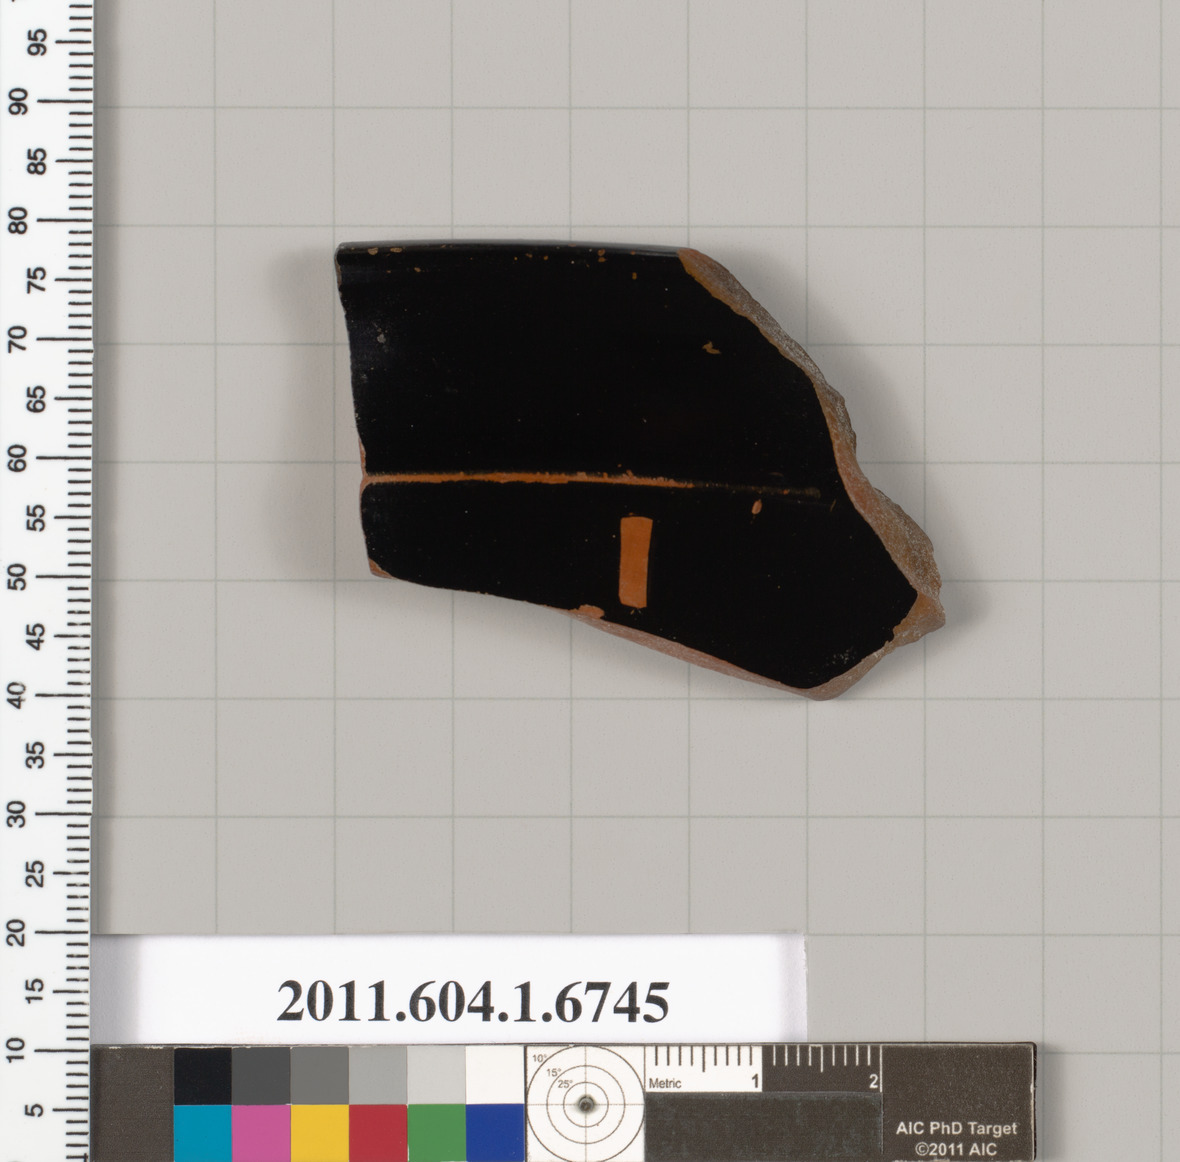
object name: kylix fragment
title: Terracotta rim fragment of a kylix (drinking cup)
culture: greek, attic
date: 490-470 BCE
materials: terracotta